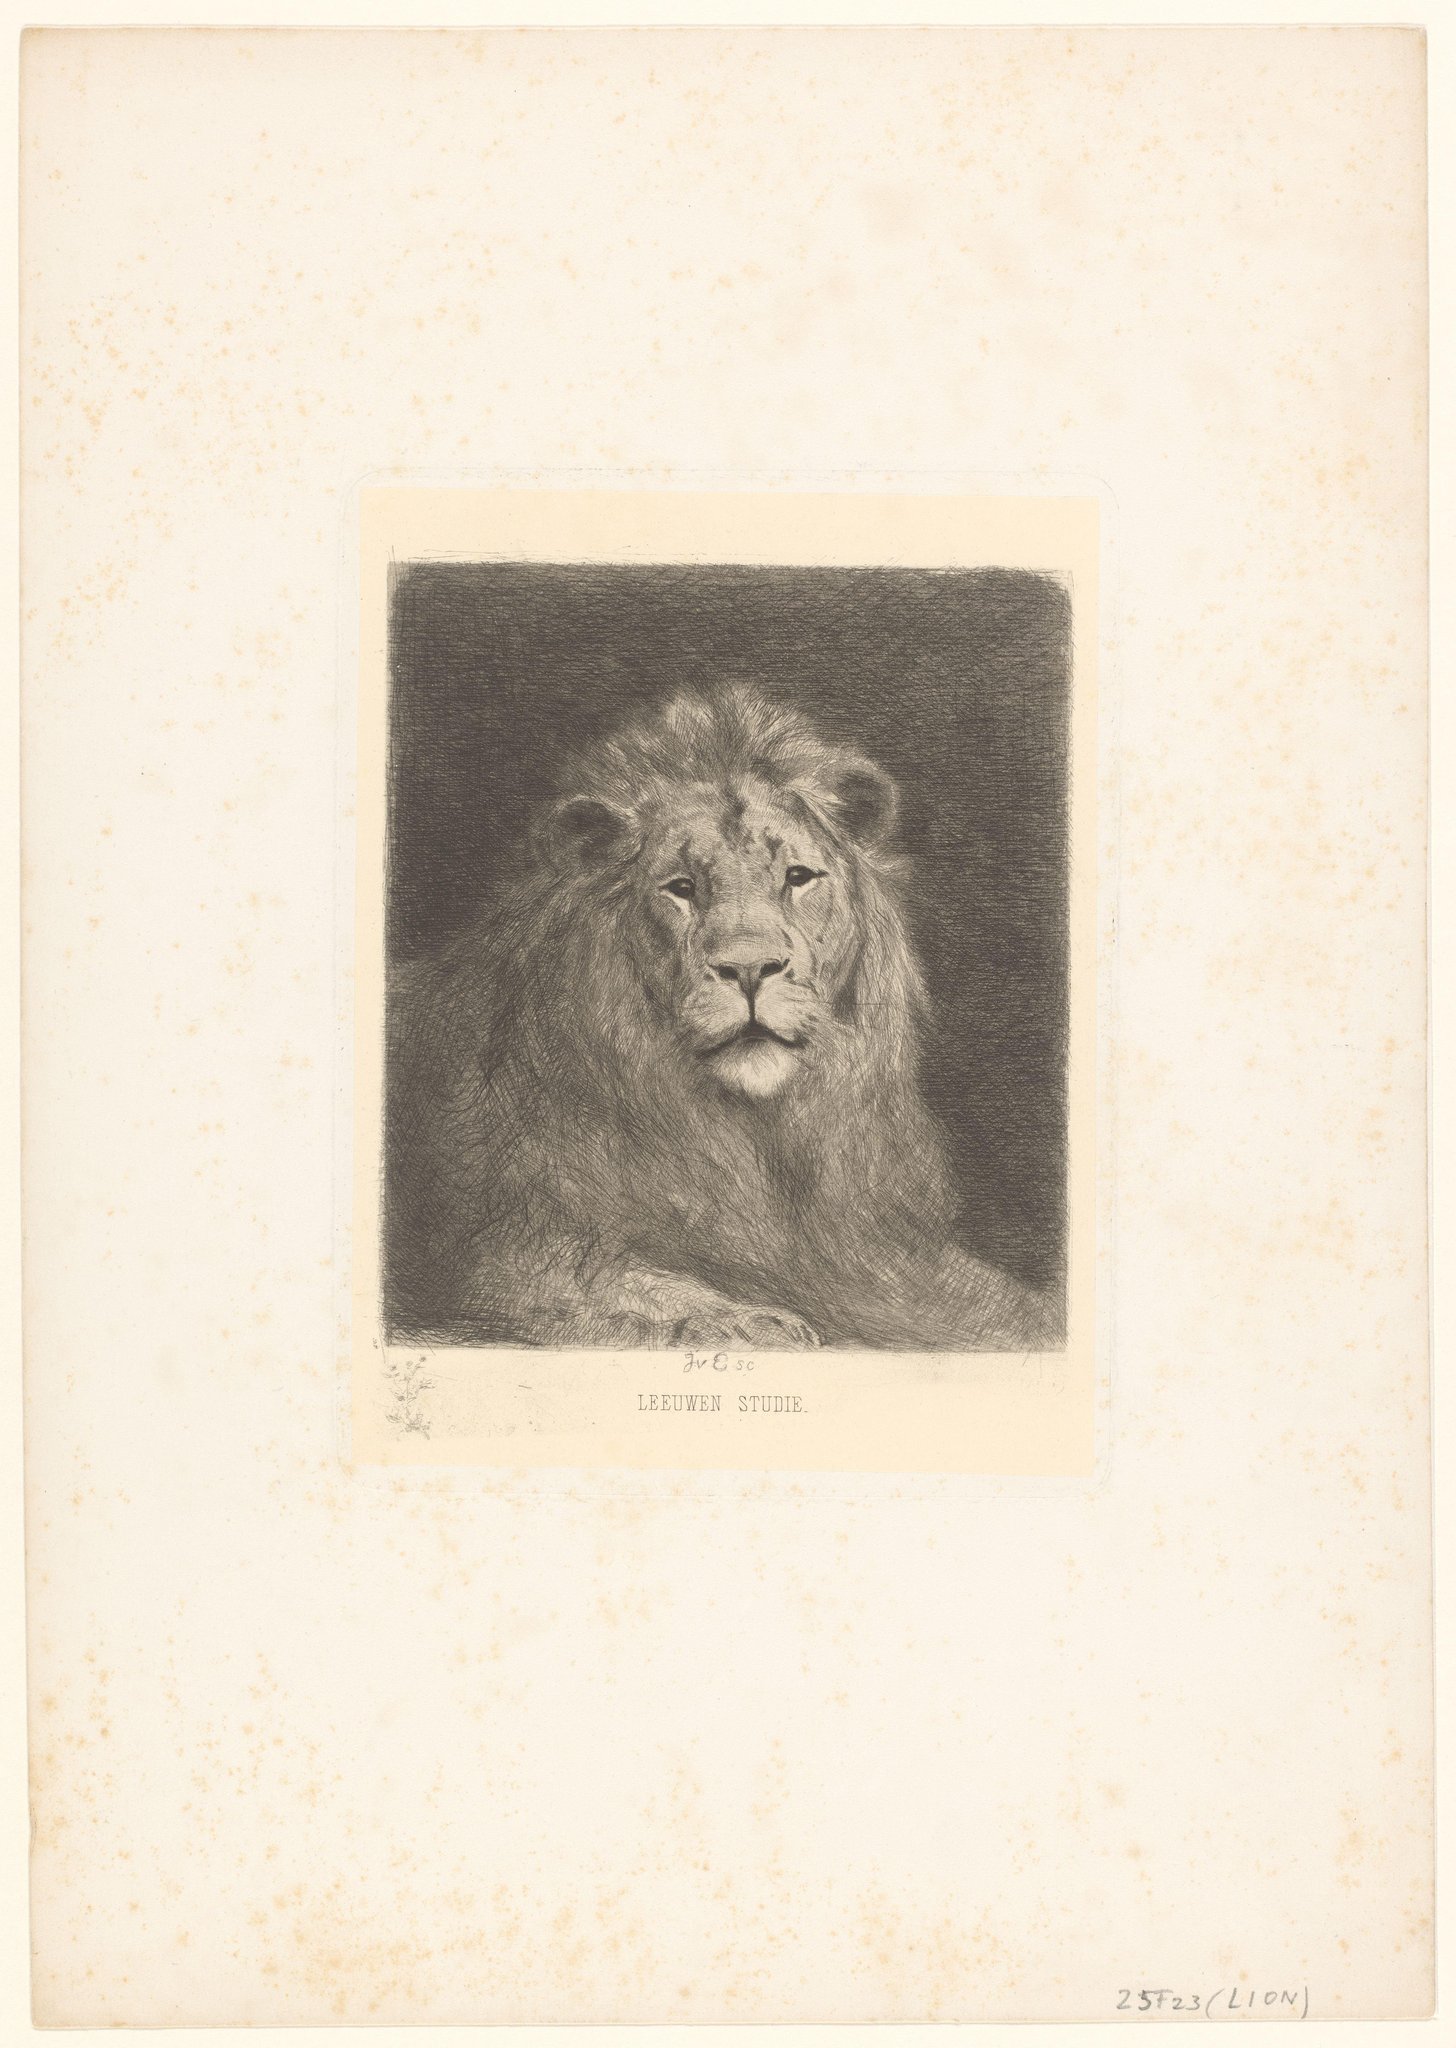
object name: print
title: Leeuwen studie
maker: jan van essen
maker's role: draughtsman, print maker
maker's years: 1854-1936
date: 1880-1906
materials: paper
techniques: etching, intaglio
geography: netherlands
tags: beasts of prey, predatory animals: lion (+ head of an animal)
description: Linksonder een tak met bladeren en bloemen.